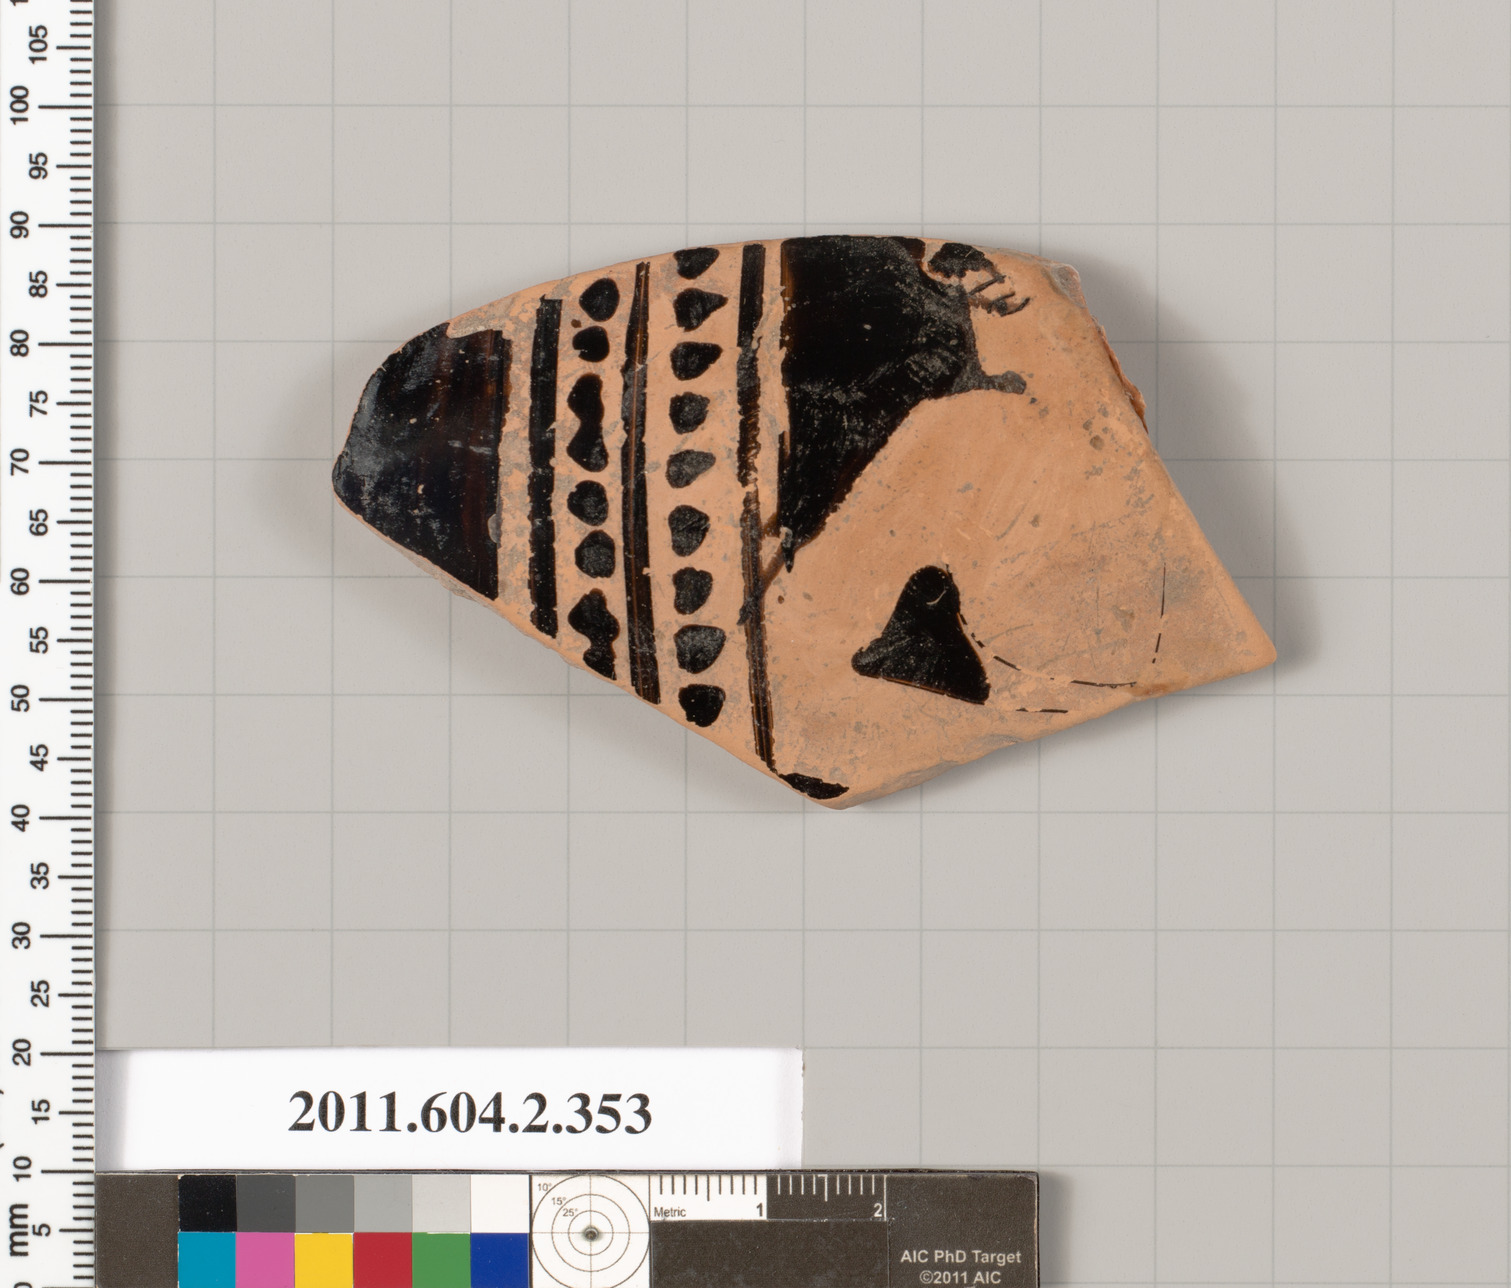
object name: column krater fragment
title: Terracotta fragment of a column-krater (bowl for mixing wine and water)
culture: greek, attic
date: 460-430 BCE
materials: terracotta